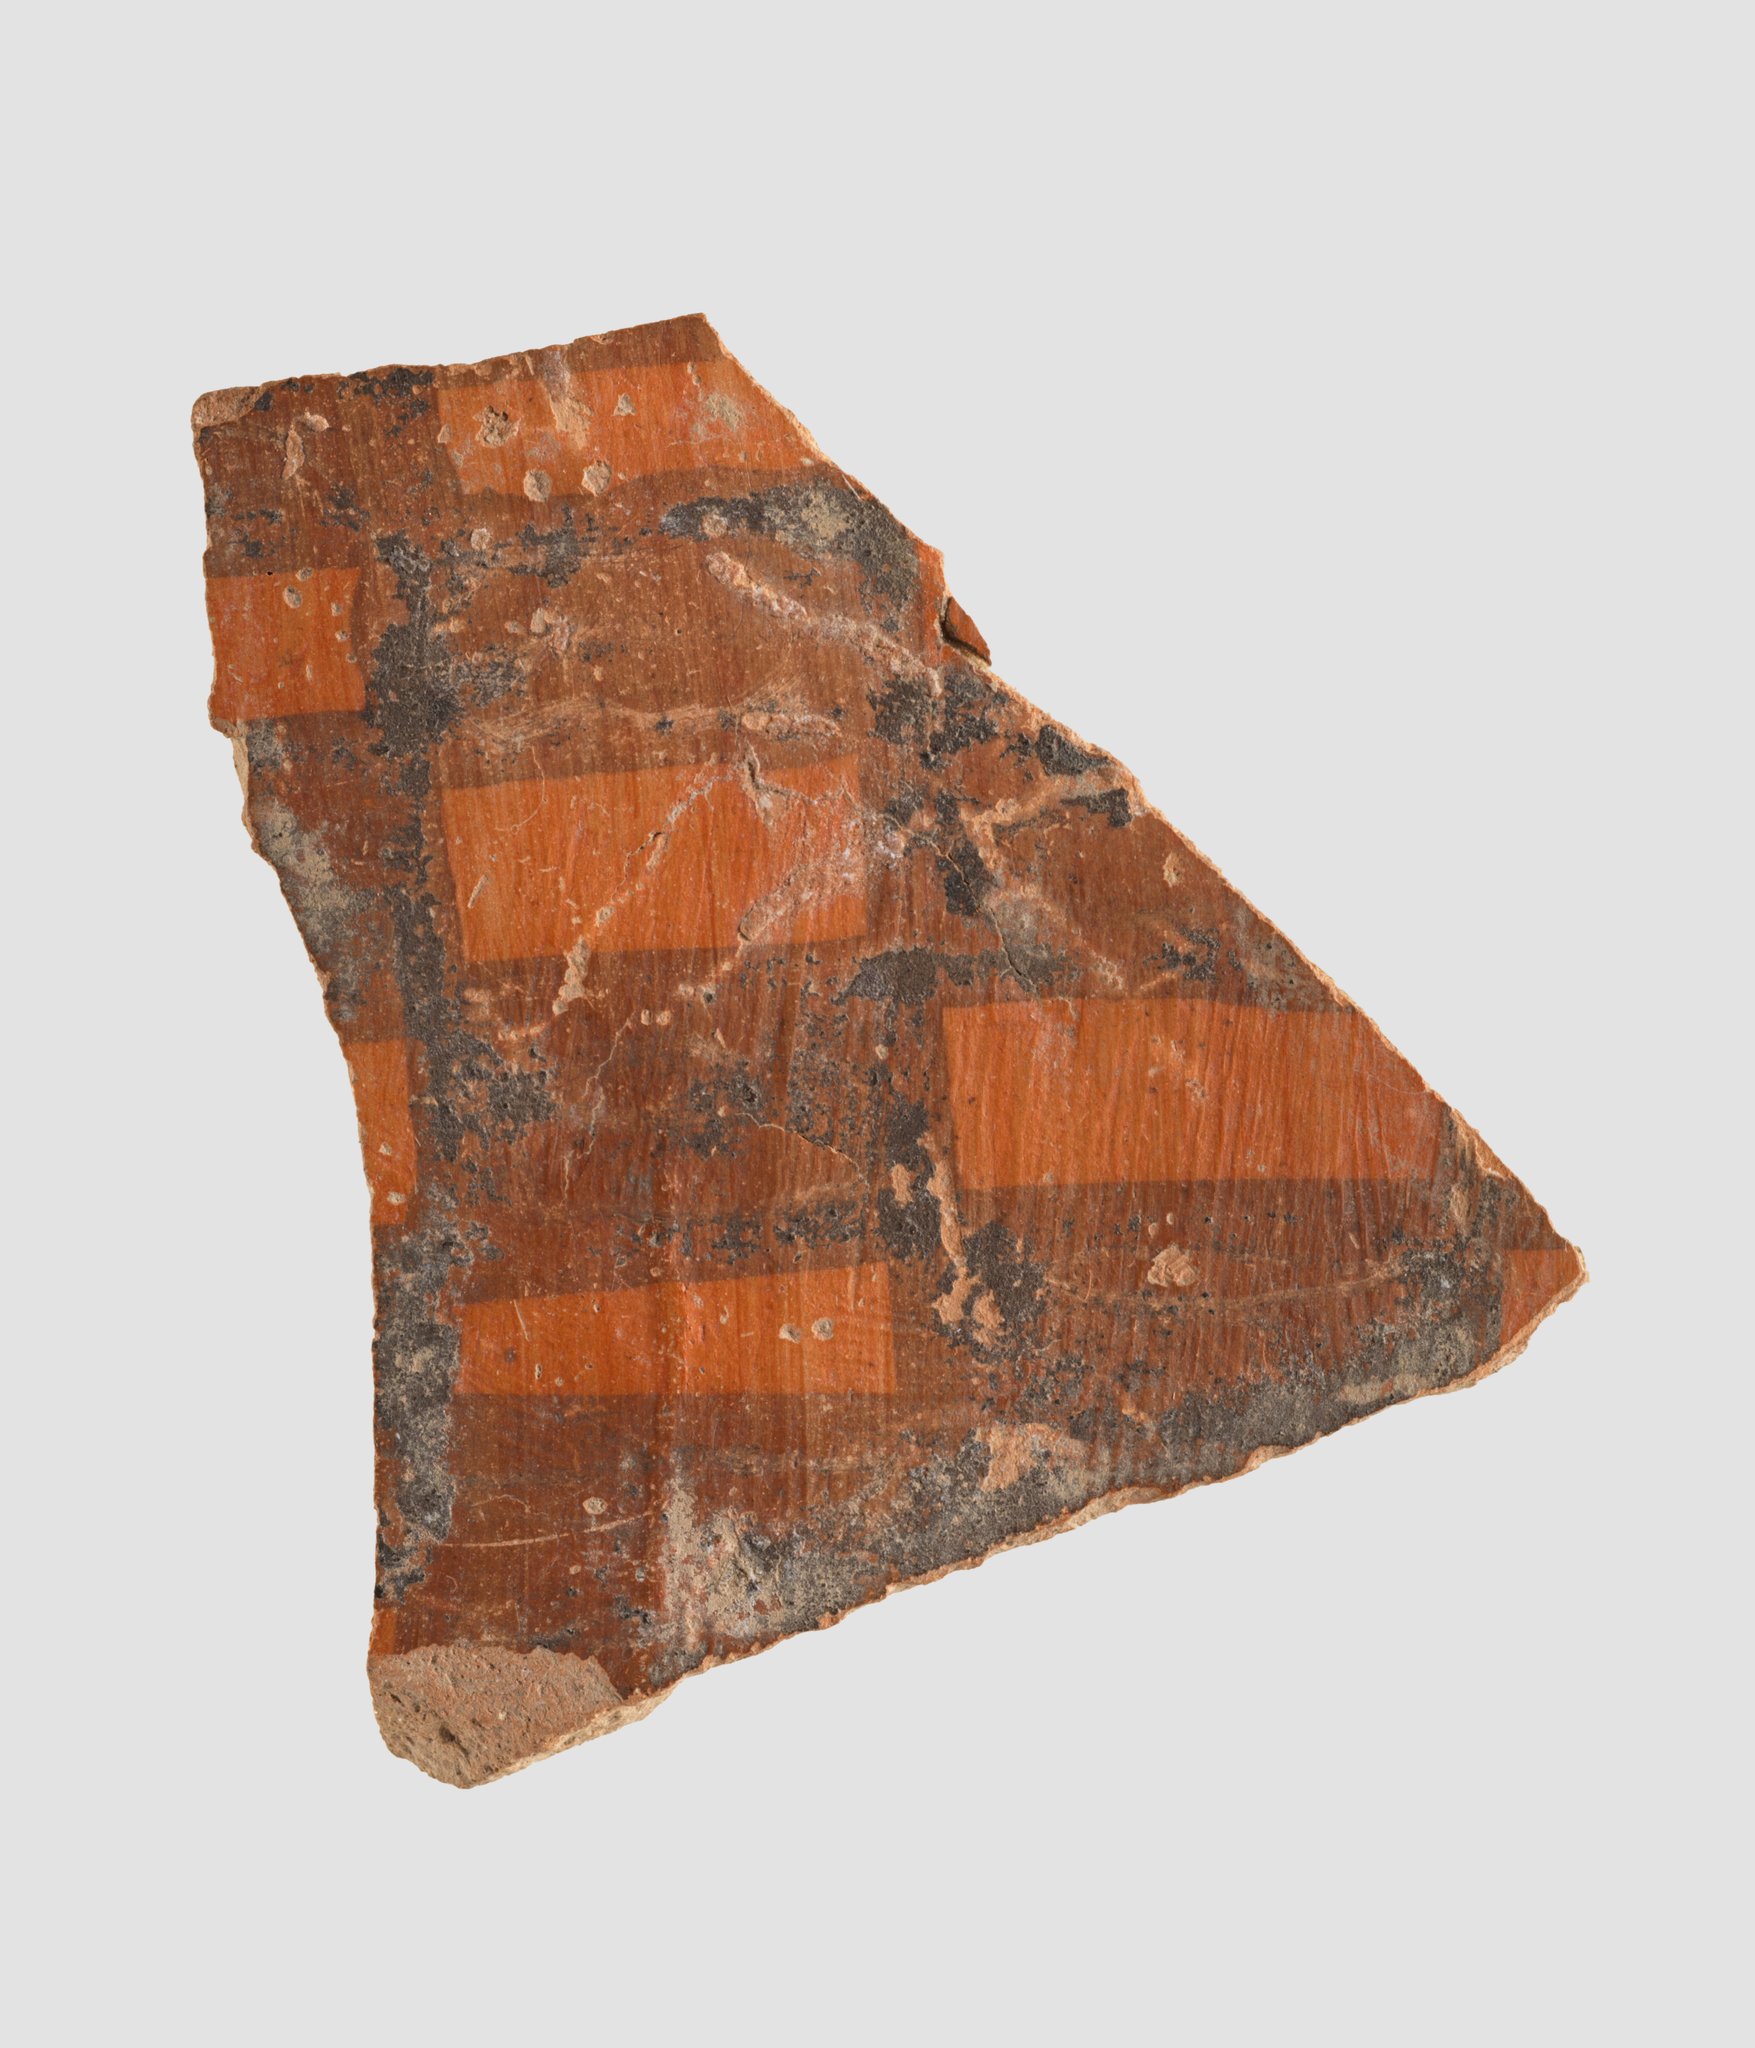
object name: sherd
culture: iranian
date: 3100-2700 BCE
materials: ceramic, paint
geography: iran